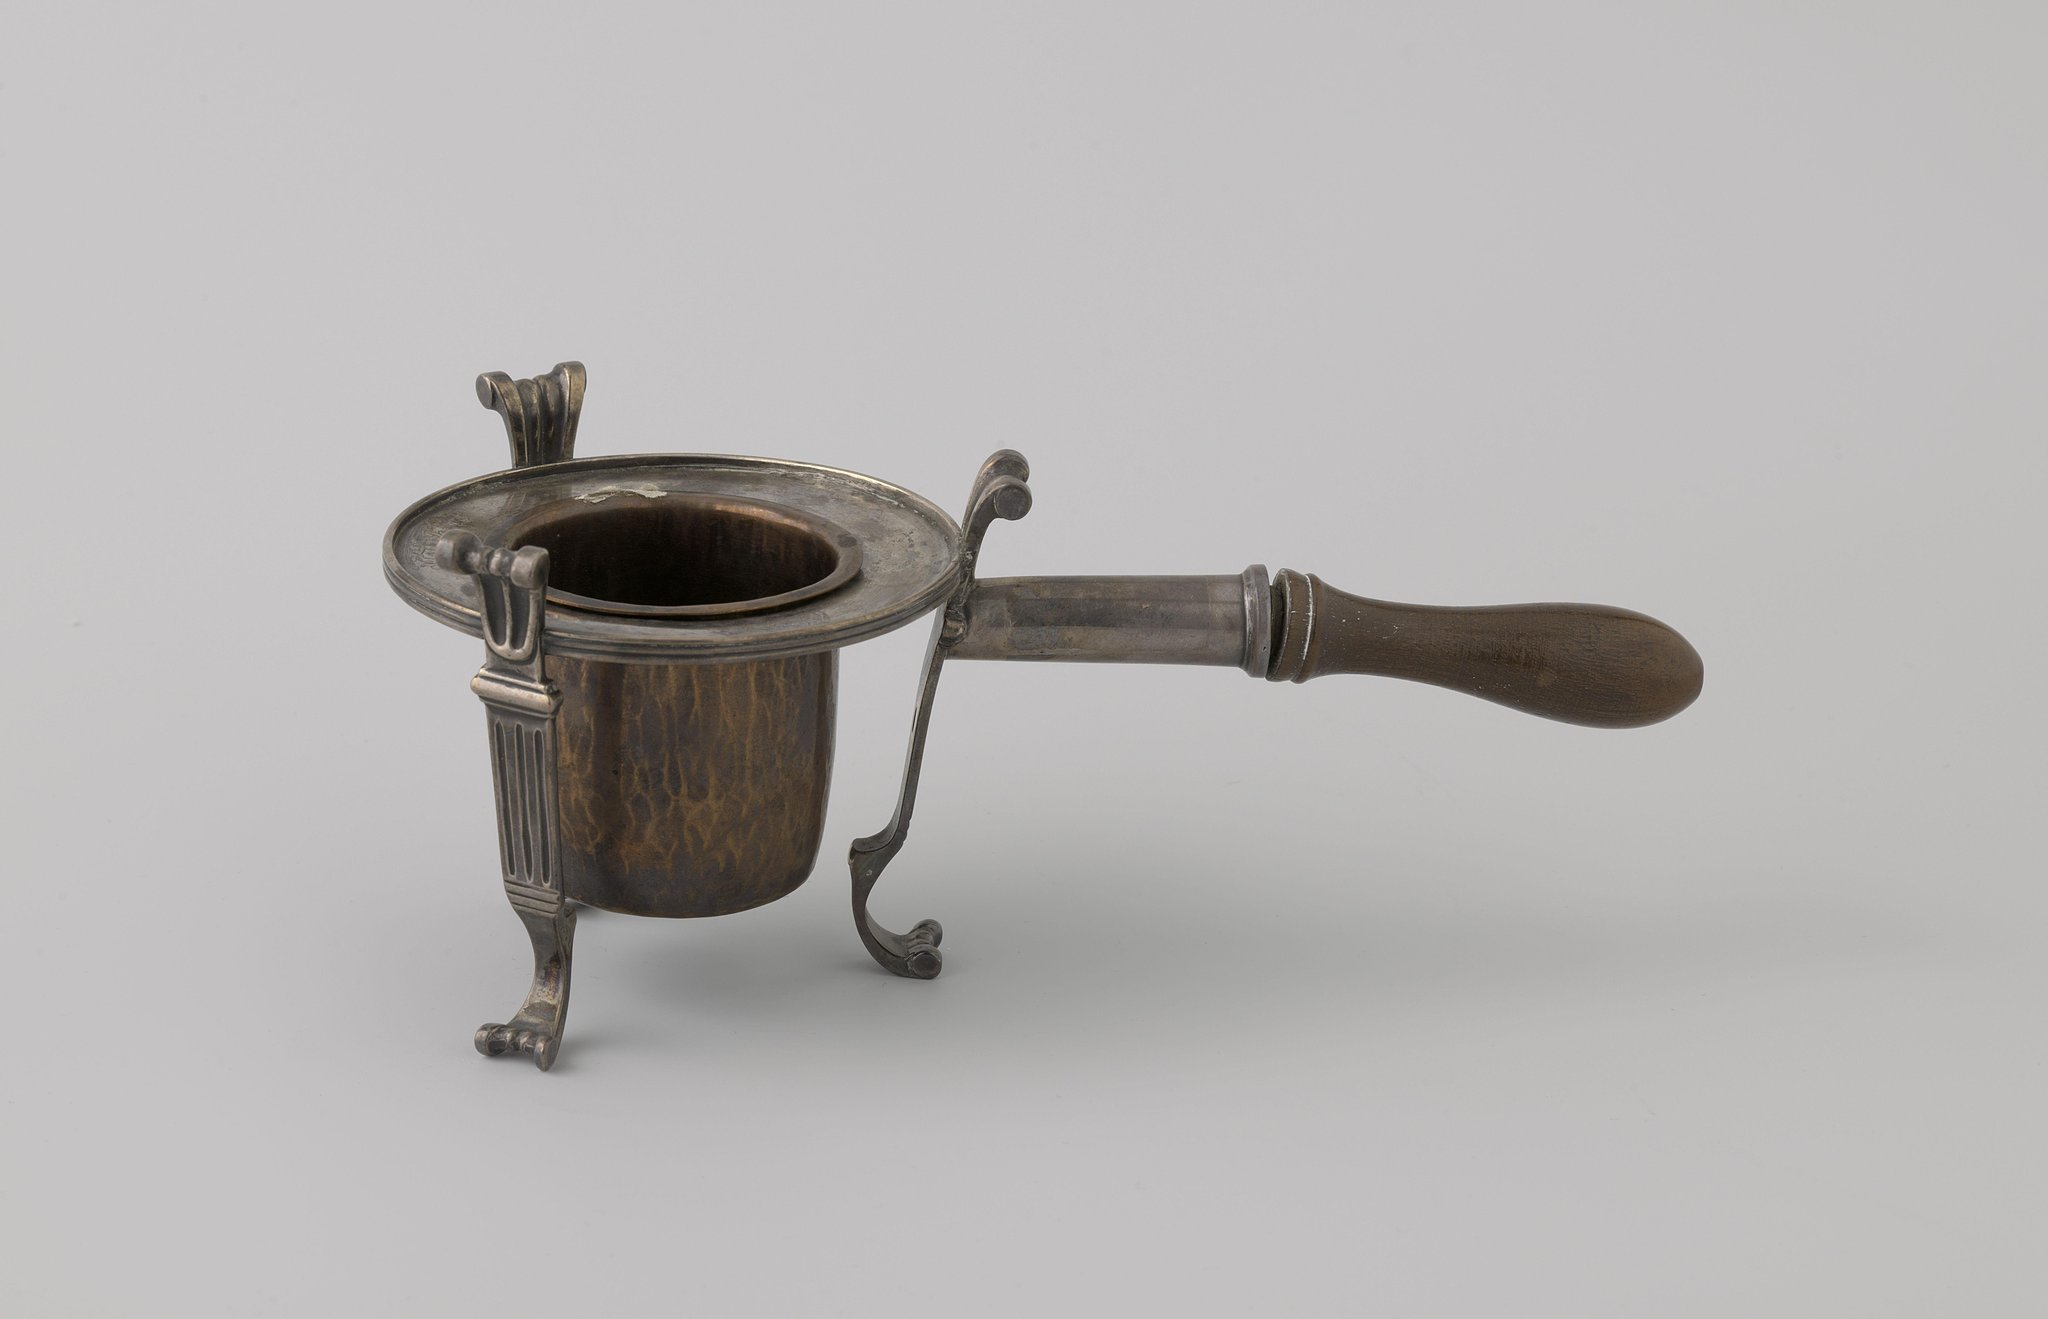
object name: komfoor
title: Komfoor van zilver met steel van hout. Binnenbak van koper.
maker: Anonymous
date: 1809-1819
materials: copper, silver, wood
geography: france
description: Komfoor van zilver met diep koperen bakje en een houten steel. Meesterteken: vrouwekop in ovaal.